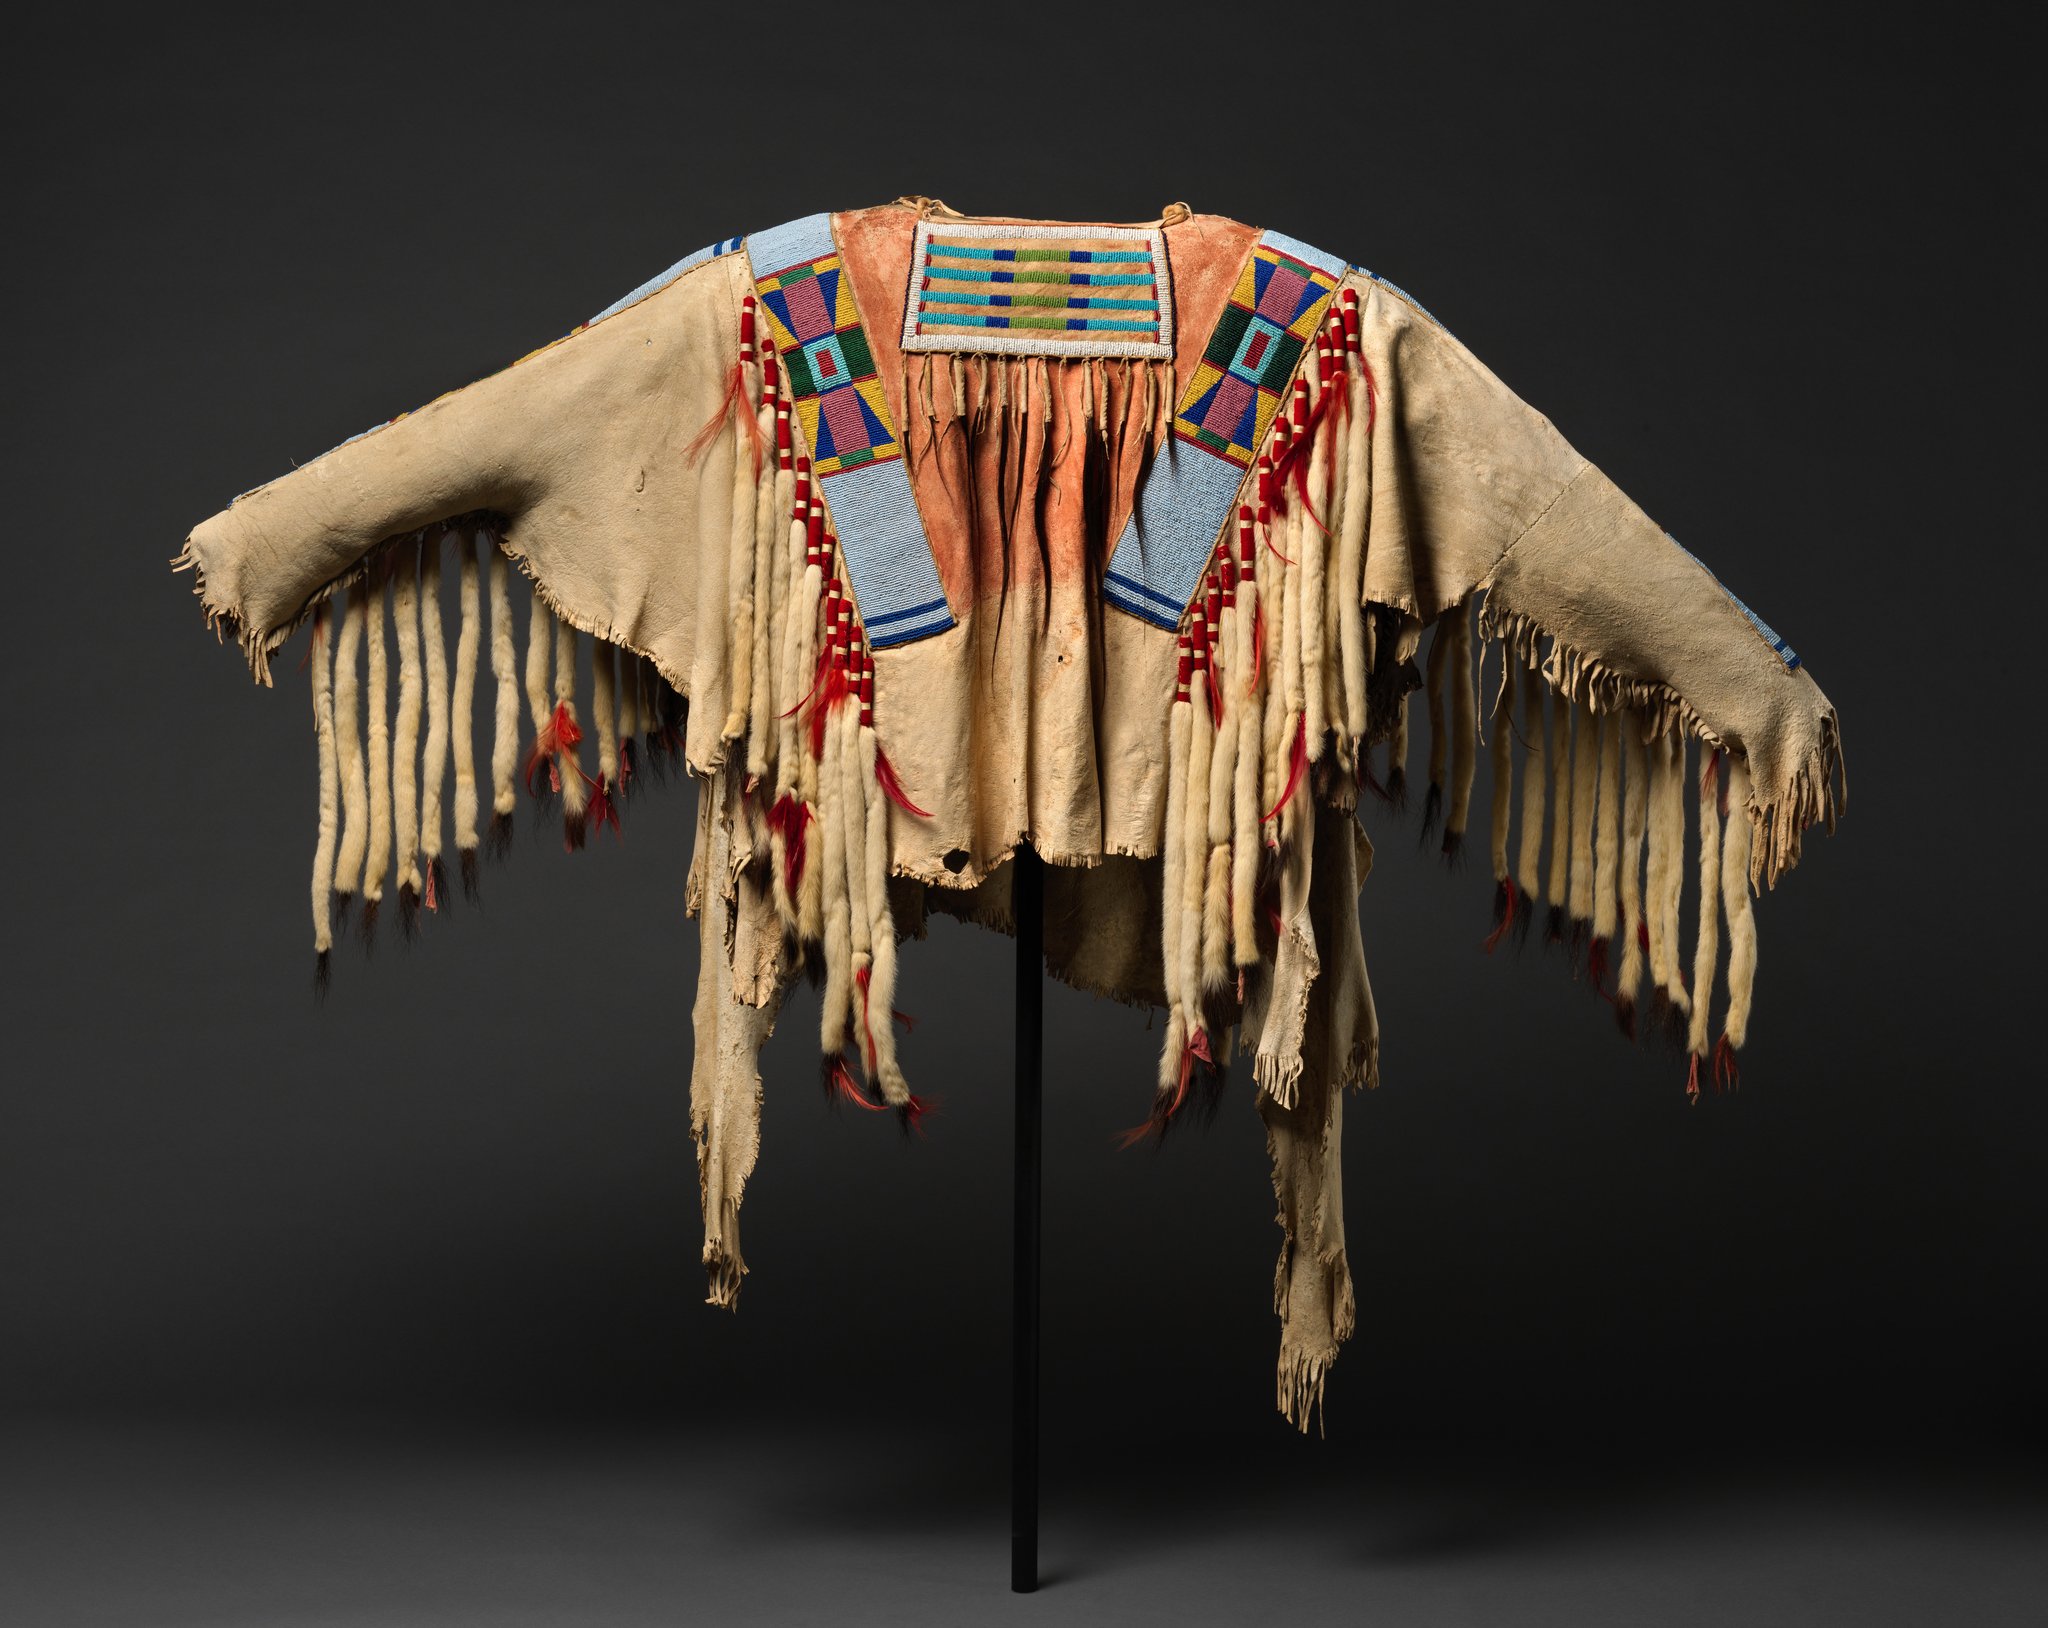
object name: war shirt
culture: crow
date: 1880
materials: textile, feather, glass, hair, leather, pigment, wool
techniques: tanning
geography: united states